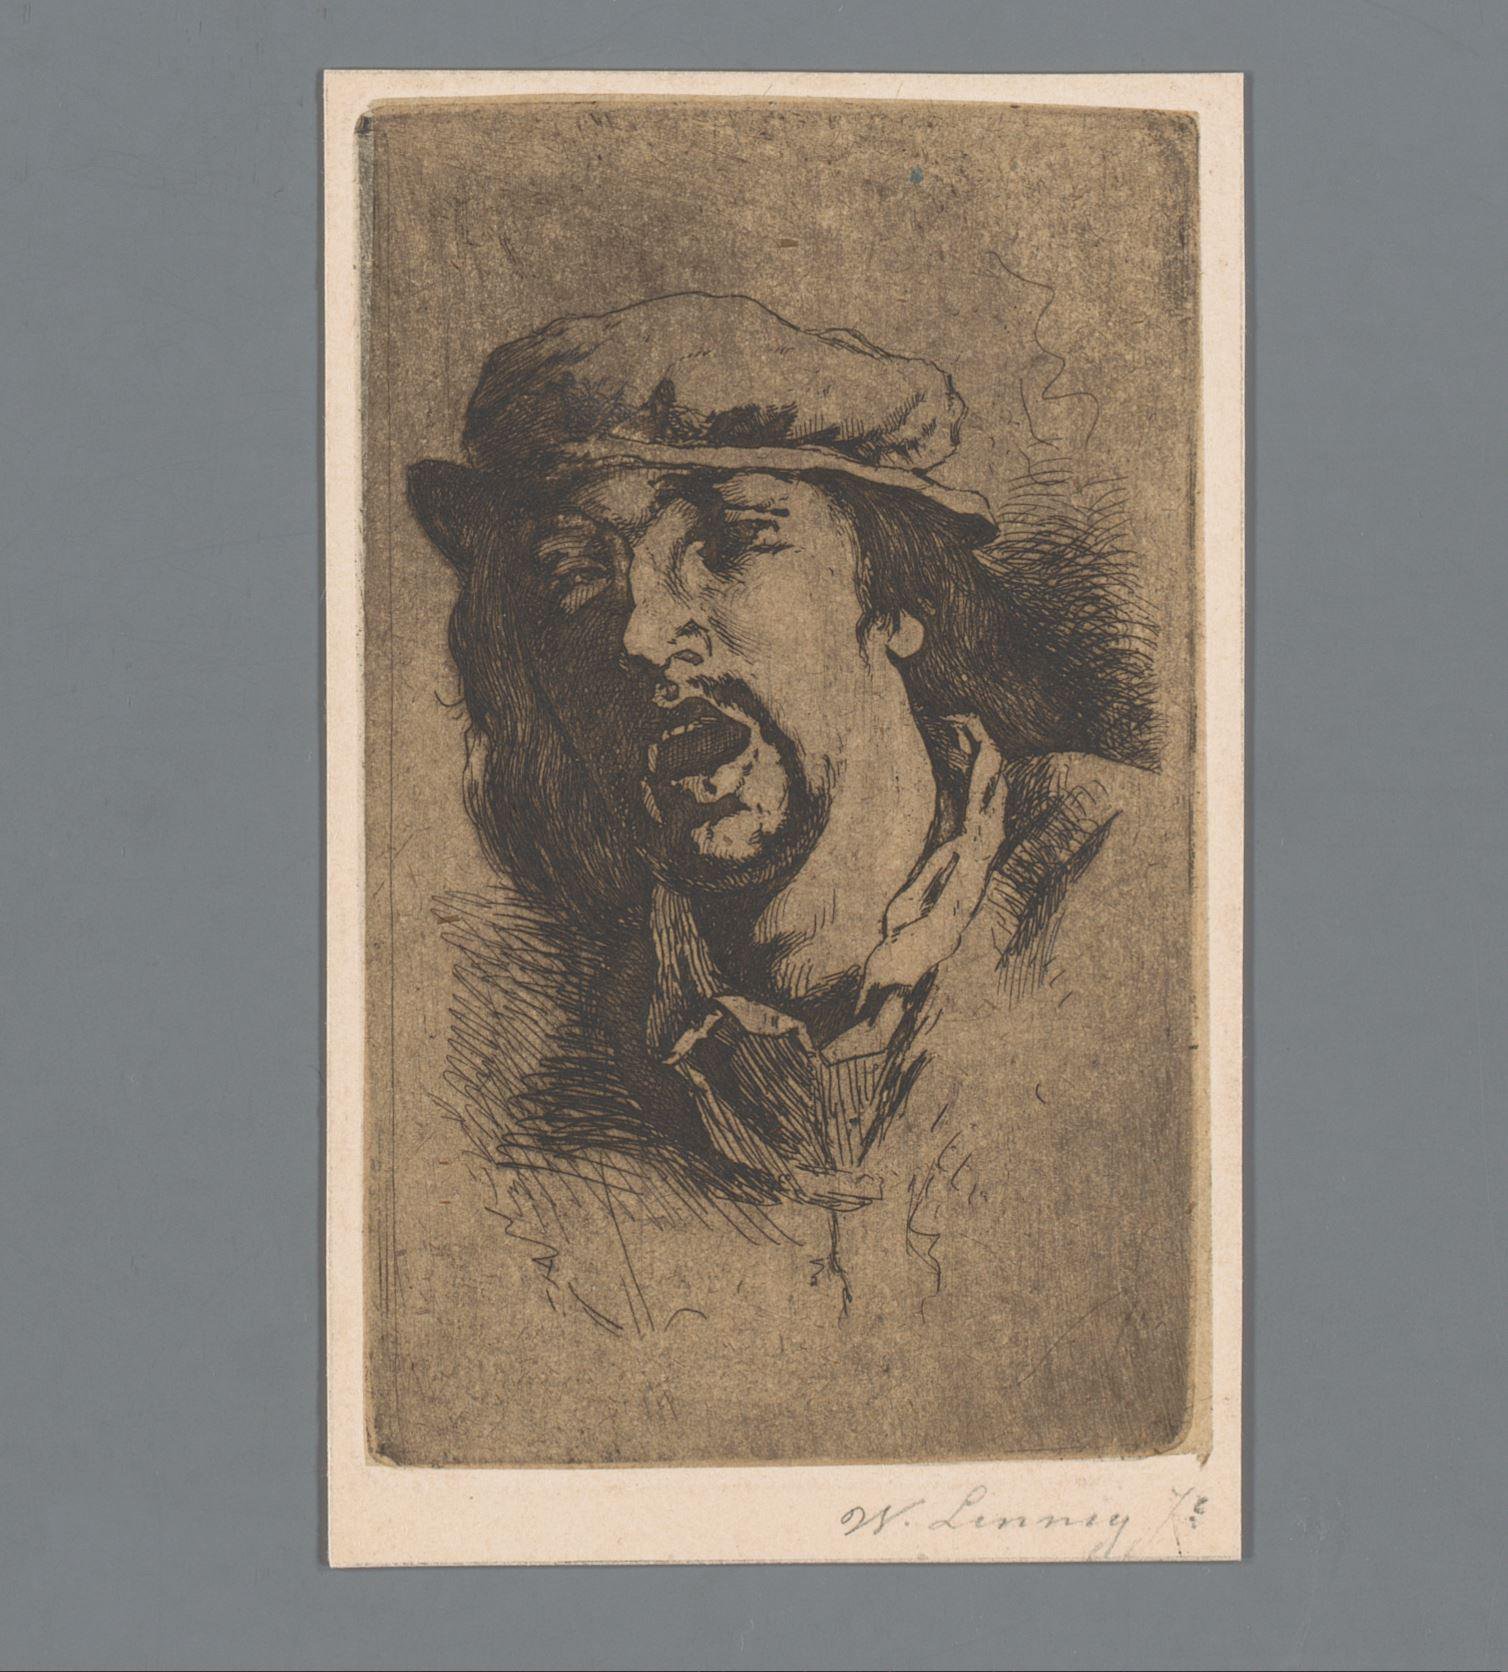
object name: print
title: Portret van een onbekende man met open mond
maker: willem linnig (ii)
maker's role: print maker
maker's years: 1842-1890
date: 1852-1890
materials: paper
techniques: etching, intaglio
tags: anonymous historical person portrayed alone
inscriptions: collector's mark: Lugt 2228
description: Het gezicht van de man lijkt sterk op het iets uitgebreidere portret RP-P-1912-905.